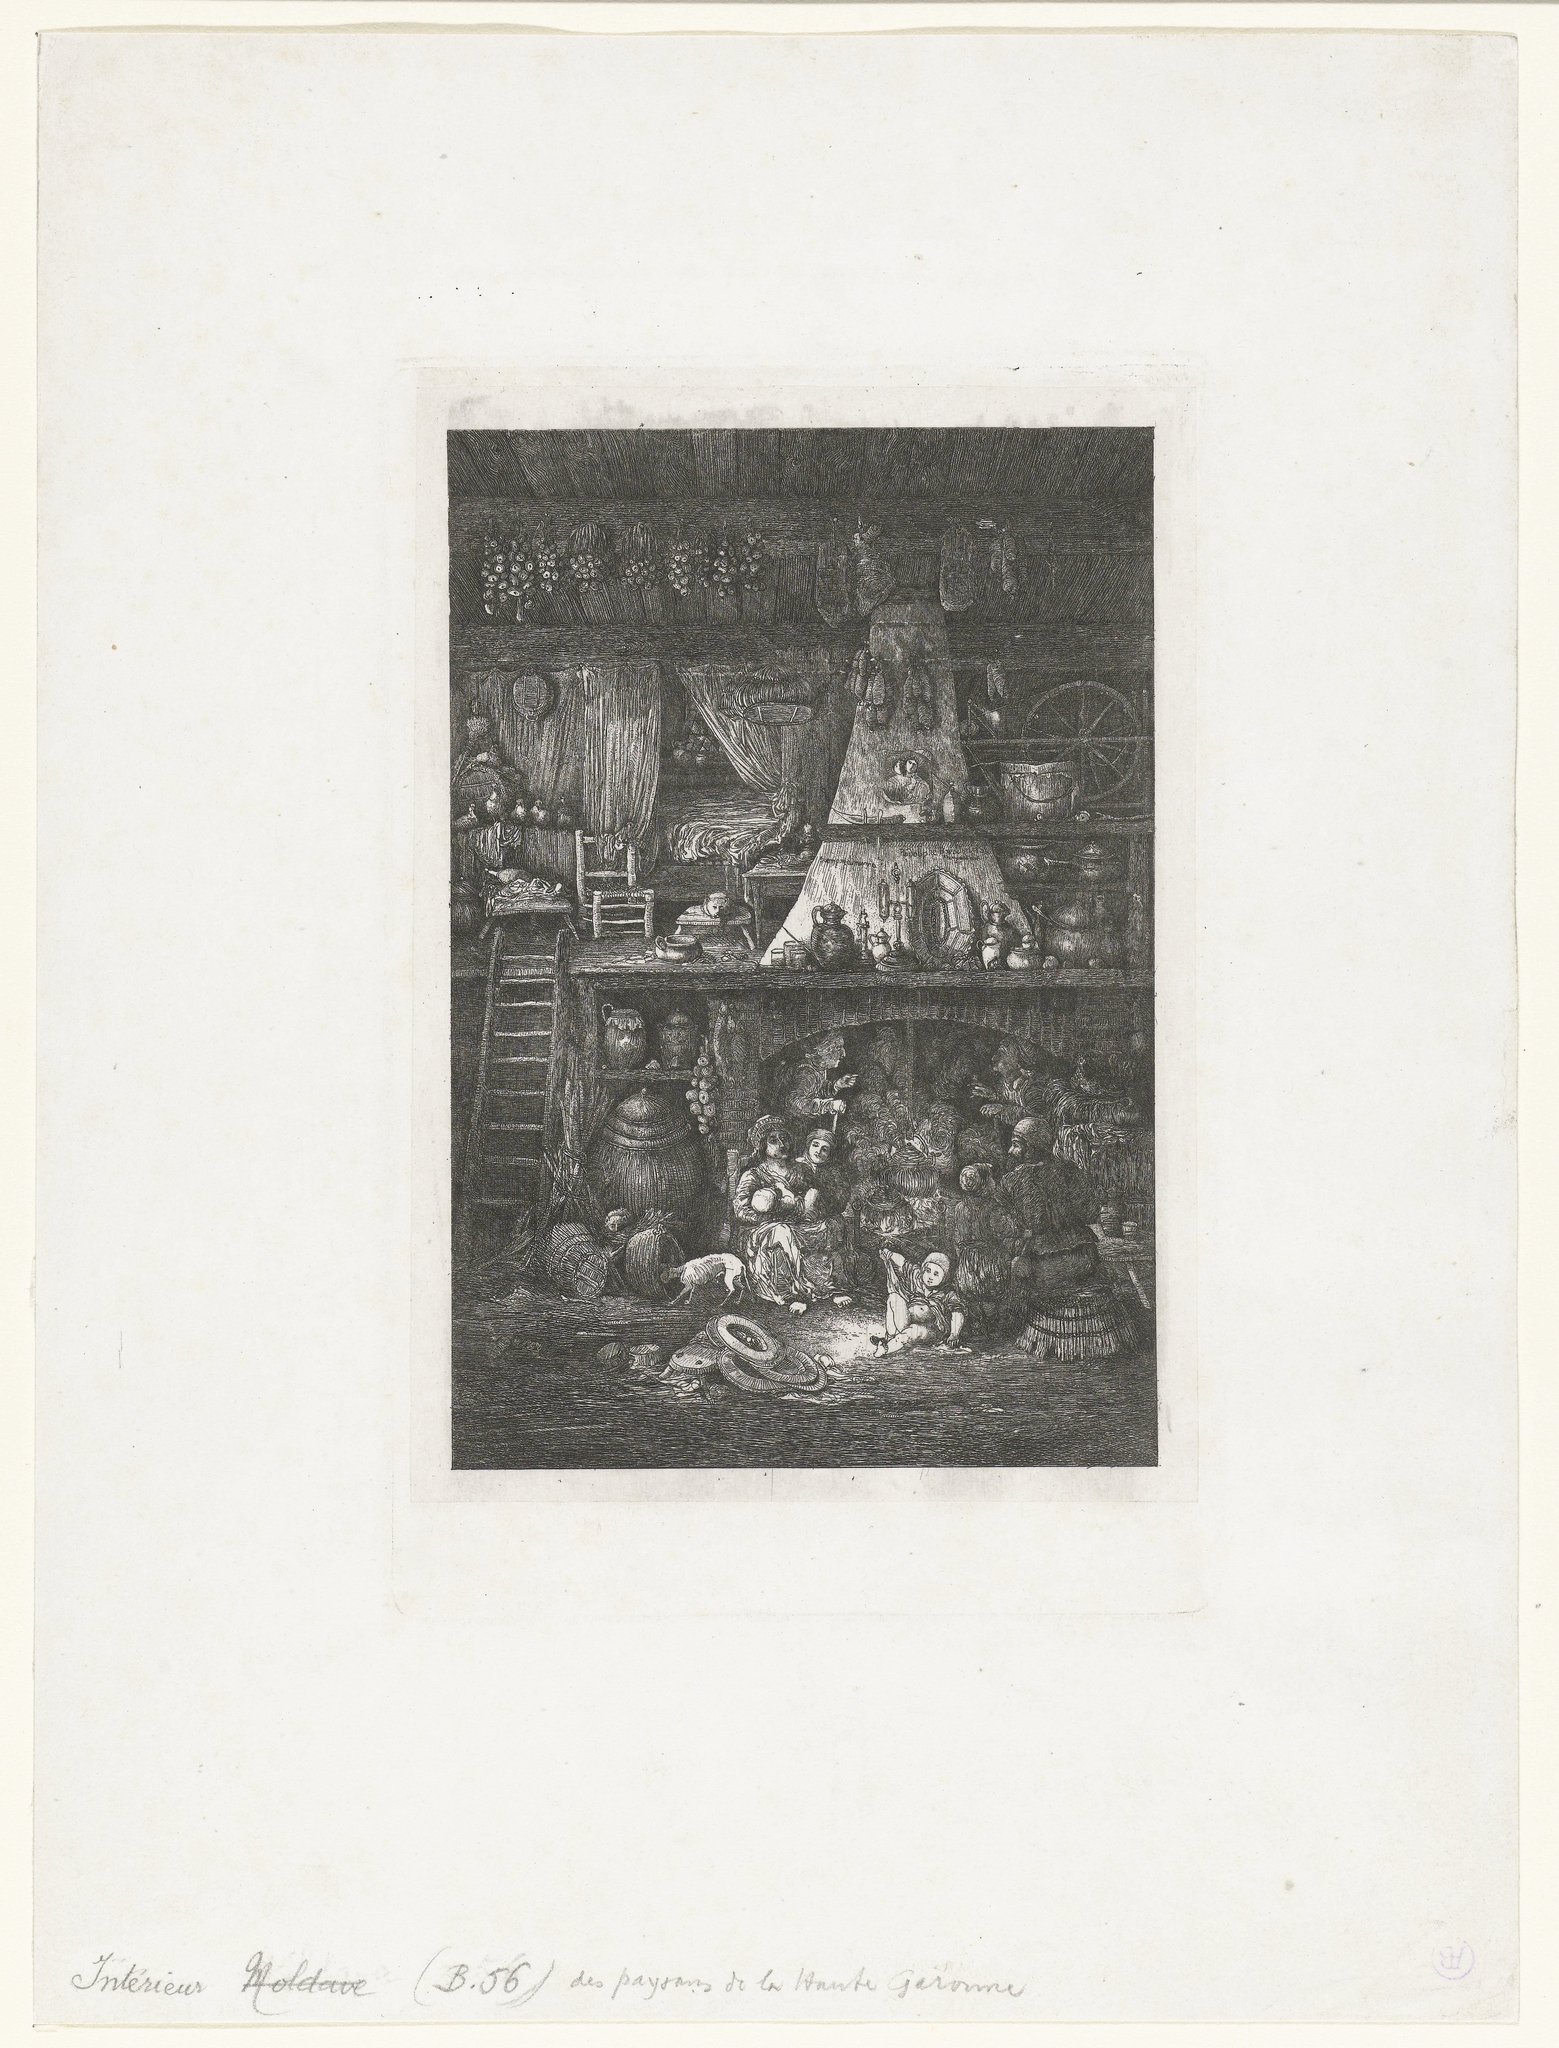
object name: print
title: Intérieur de paysans de la Haute-Garonne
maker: rodolphe bresdin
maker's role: draughtsman, print maker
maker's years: 1822-1885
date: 1858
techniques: printmaking, etching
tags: farmers, interior of the house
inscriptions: collector's mark: Lugt 2228, collector's mark: Lugt 76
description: Een boerenfamilie met kleine kinderen maar ook een oude man en vrouw zit bij een haard. Het interieur is rijk aan details. Op de schouw staan verschillende voorwerpen uit het huishouden en er hangen etenswaren te drogen aan de balken van het plafond. Een laddertje links leidt naar een hoger gedeelte waar zich ook de bedstede bevind.